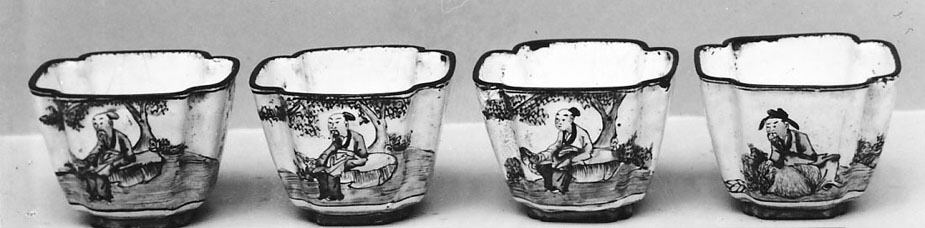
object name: cup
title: Square Cup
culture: chinese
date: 1736-1795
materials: enamel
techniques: painting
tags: men,trees